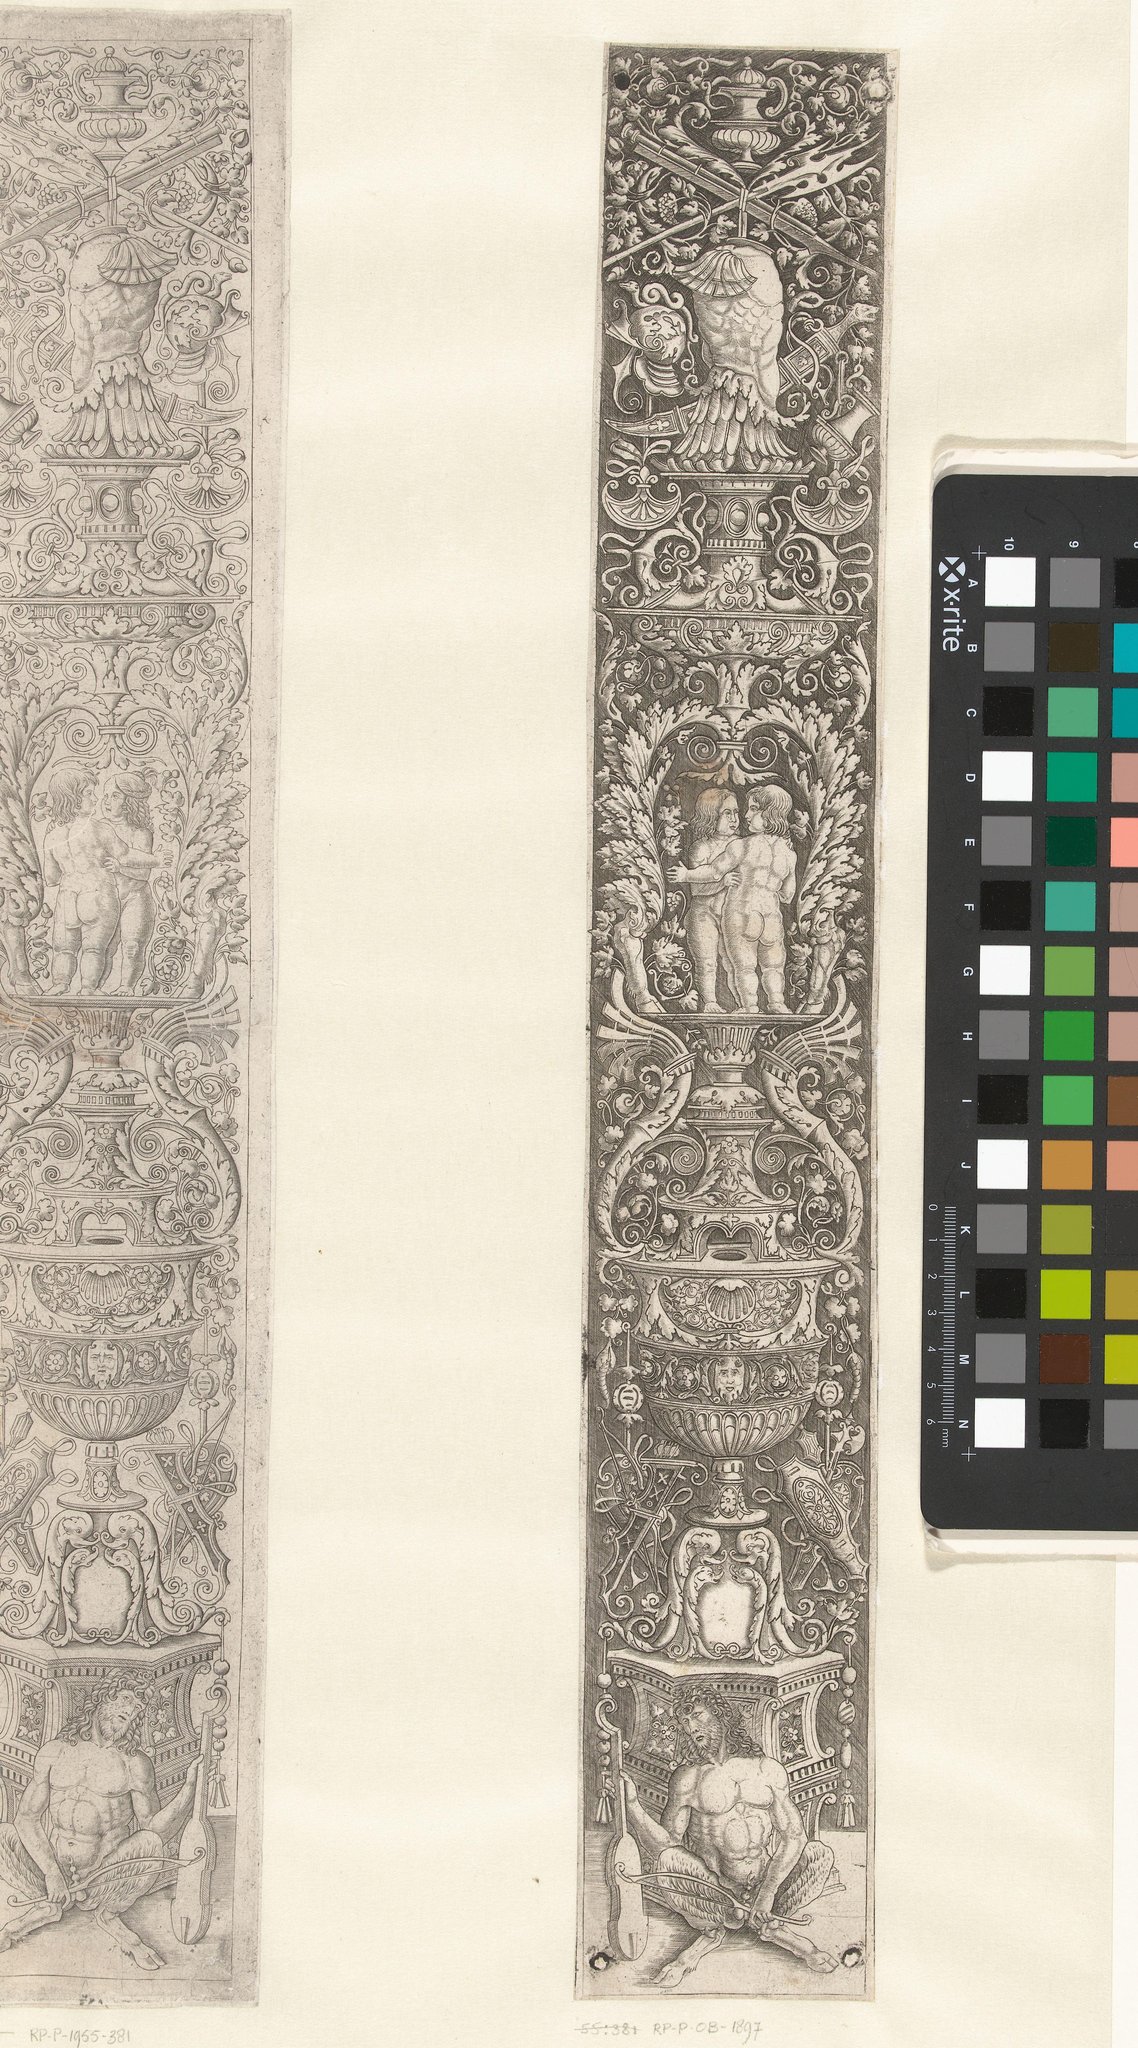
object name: ornament print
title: Kandelaber met satyr met viool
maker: Anonymous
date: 1505-1565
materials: paper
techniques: engraving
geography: italy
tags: chandelier, candelabrum, harness, satyr(s) (in general)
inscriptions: collector's mark: Lugt 240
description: Kandelaber opgebouwd uit een satyr zittend met een viool voor een sokkel met vaas geflankeerd door wapentrofeeën. Daarboven twee kinderen die elkaar omarmen omgeven door bladranken en bekroning met borstkuras van opzij gezien.